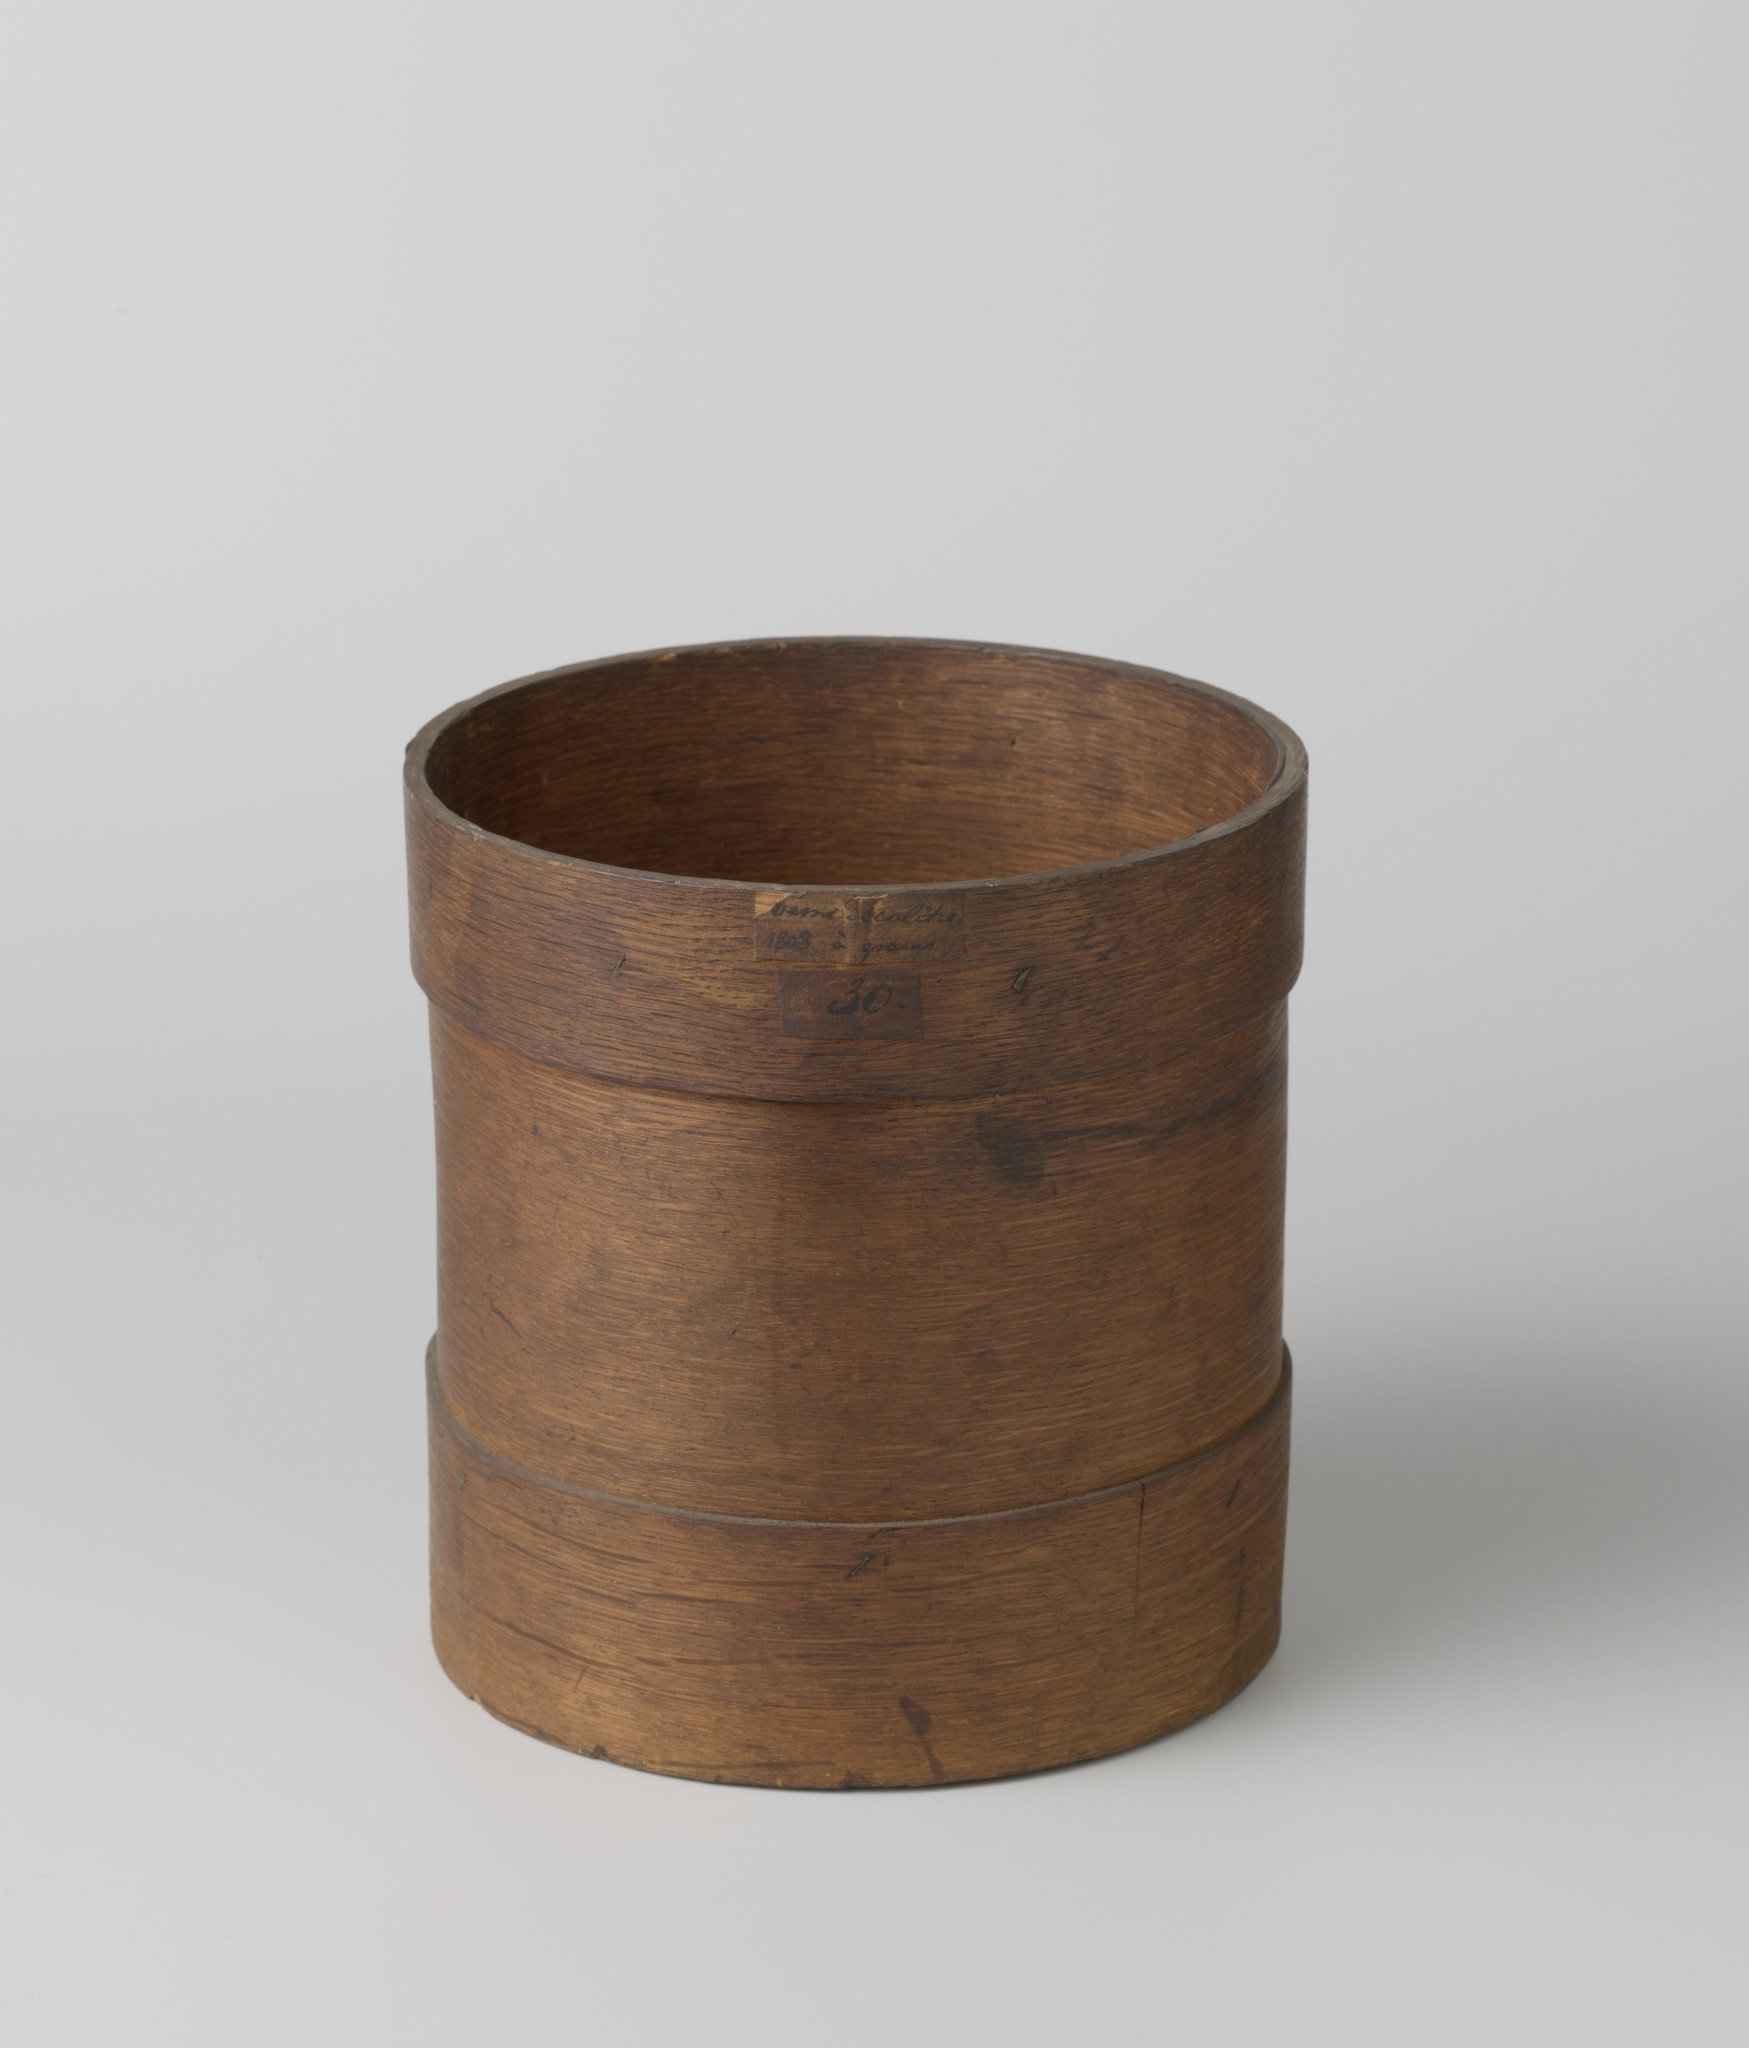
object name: inhoudsmaat droge waren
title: Inhoudsmaat van 1/2 decaliter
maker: Anonymous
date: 1825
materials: wood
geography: netherlands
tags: netherlands